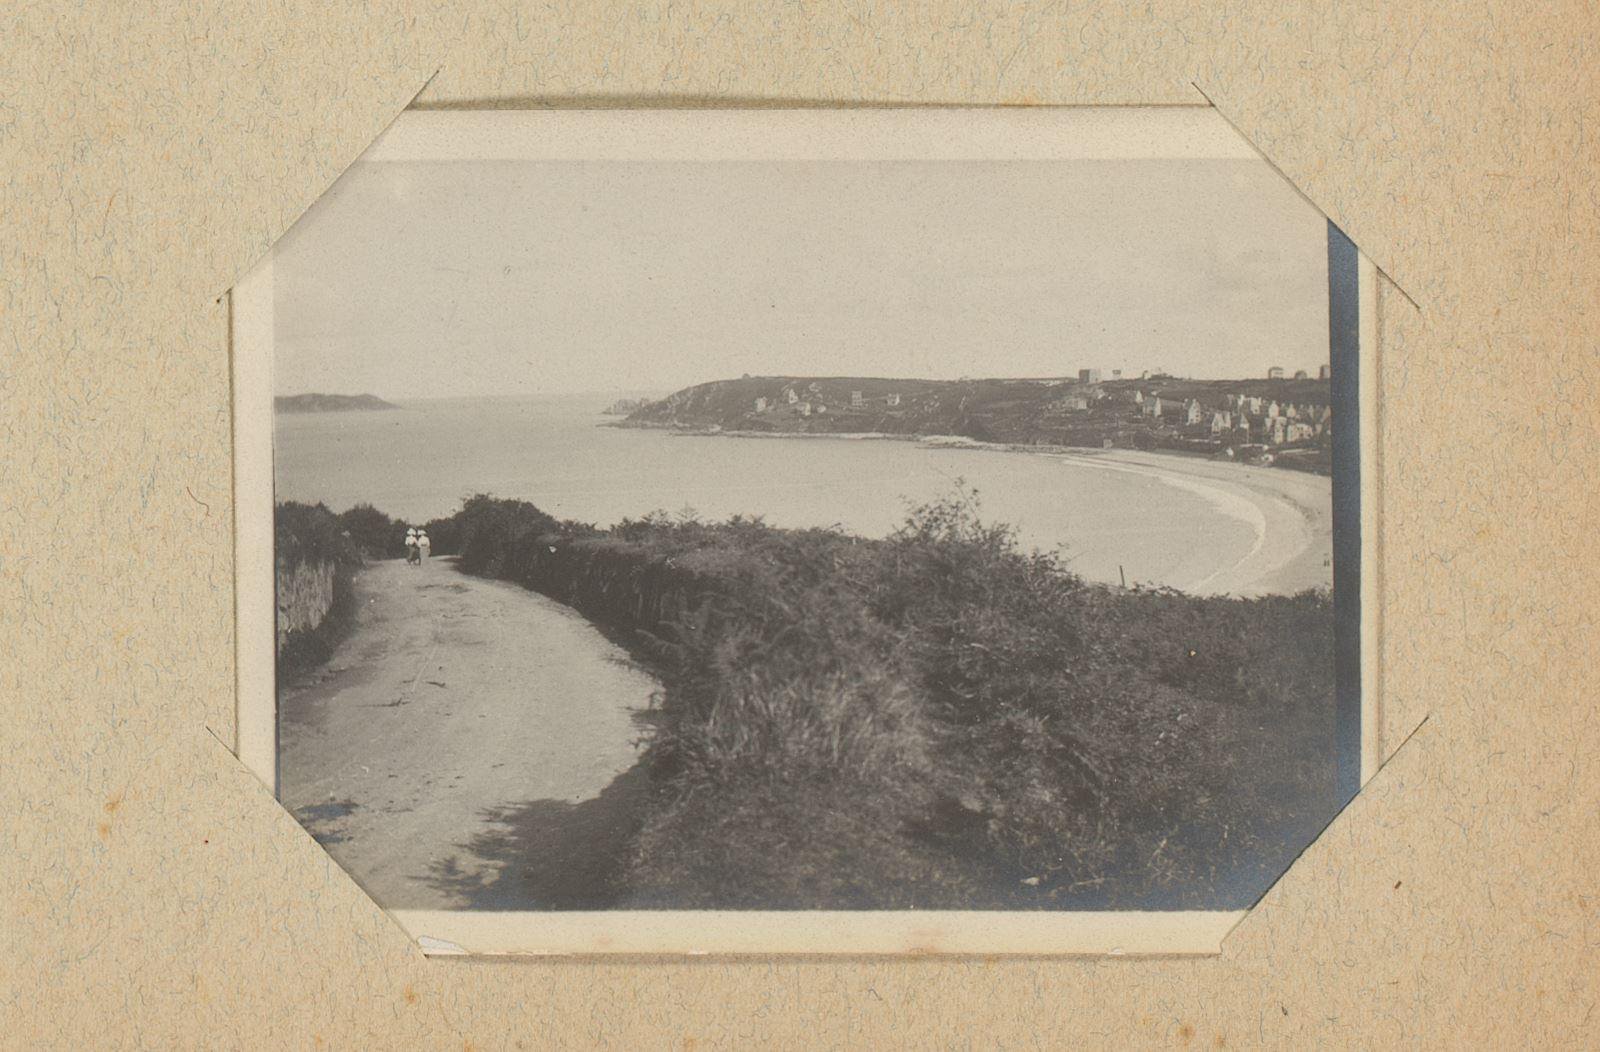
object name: photograph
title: Gezicht op een baai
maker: Anonymous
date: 1897-1900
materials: paper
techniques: gelatin silver print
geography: france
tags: gulf, bay, france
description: Over de foto is een ander negatief afgedrukt van een voorstelling van bomen.